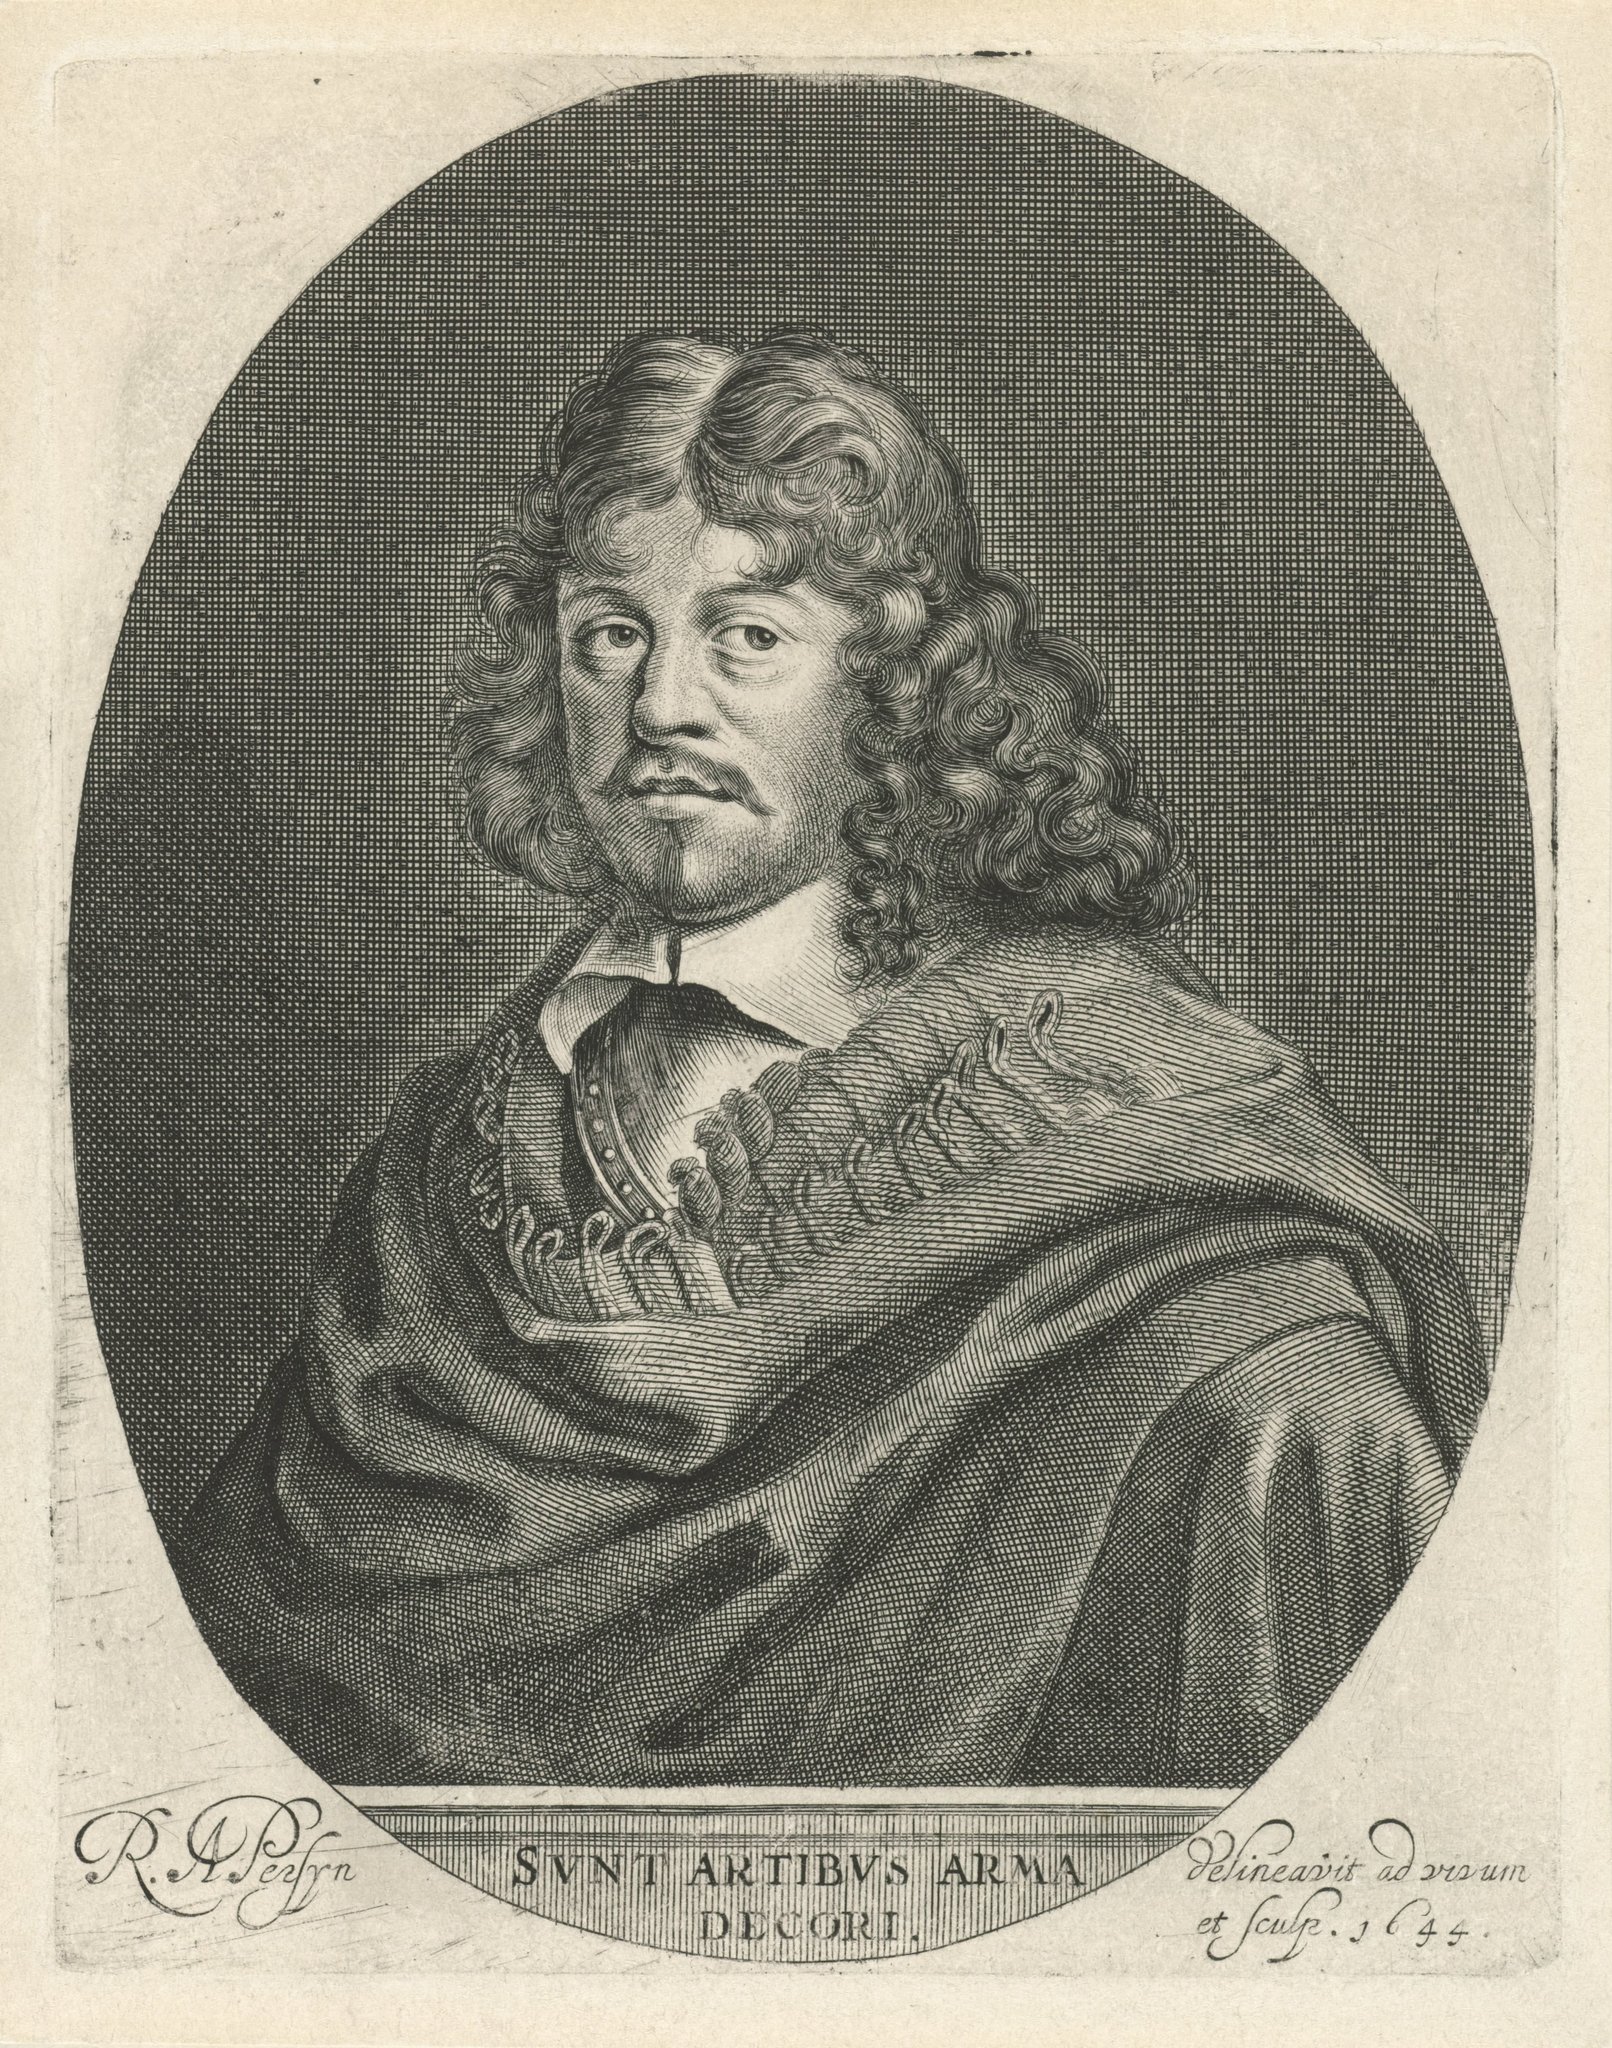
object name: print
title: Portret van Ludwig von Siegen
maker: reinier van persijn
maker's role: draughtsman, painter, print maker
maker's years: 1614-1668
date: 1644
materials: paper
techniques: engraving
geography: gouda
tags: print maker, ludwig von siegen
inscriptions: collector's mark: Lugt 2228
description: Portret van Ludwig von Siegen, een Duitse soldaat, eronder zijn devies in het Latijn.